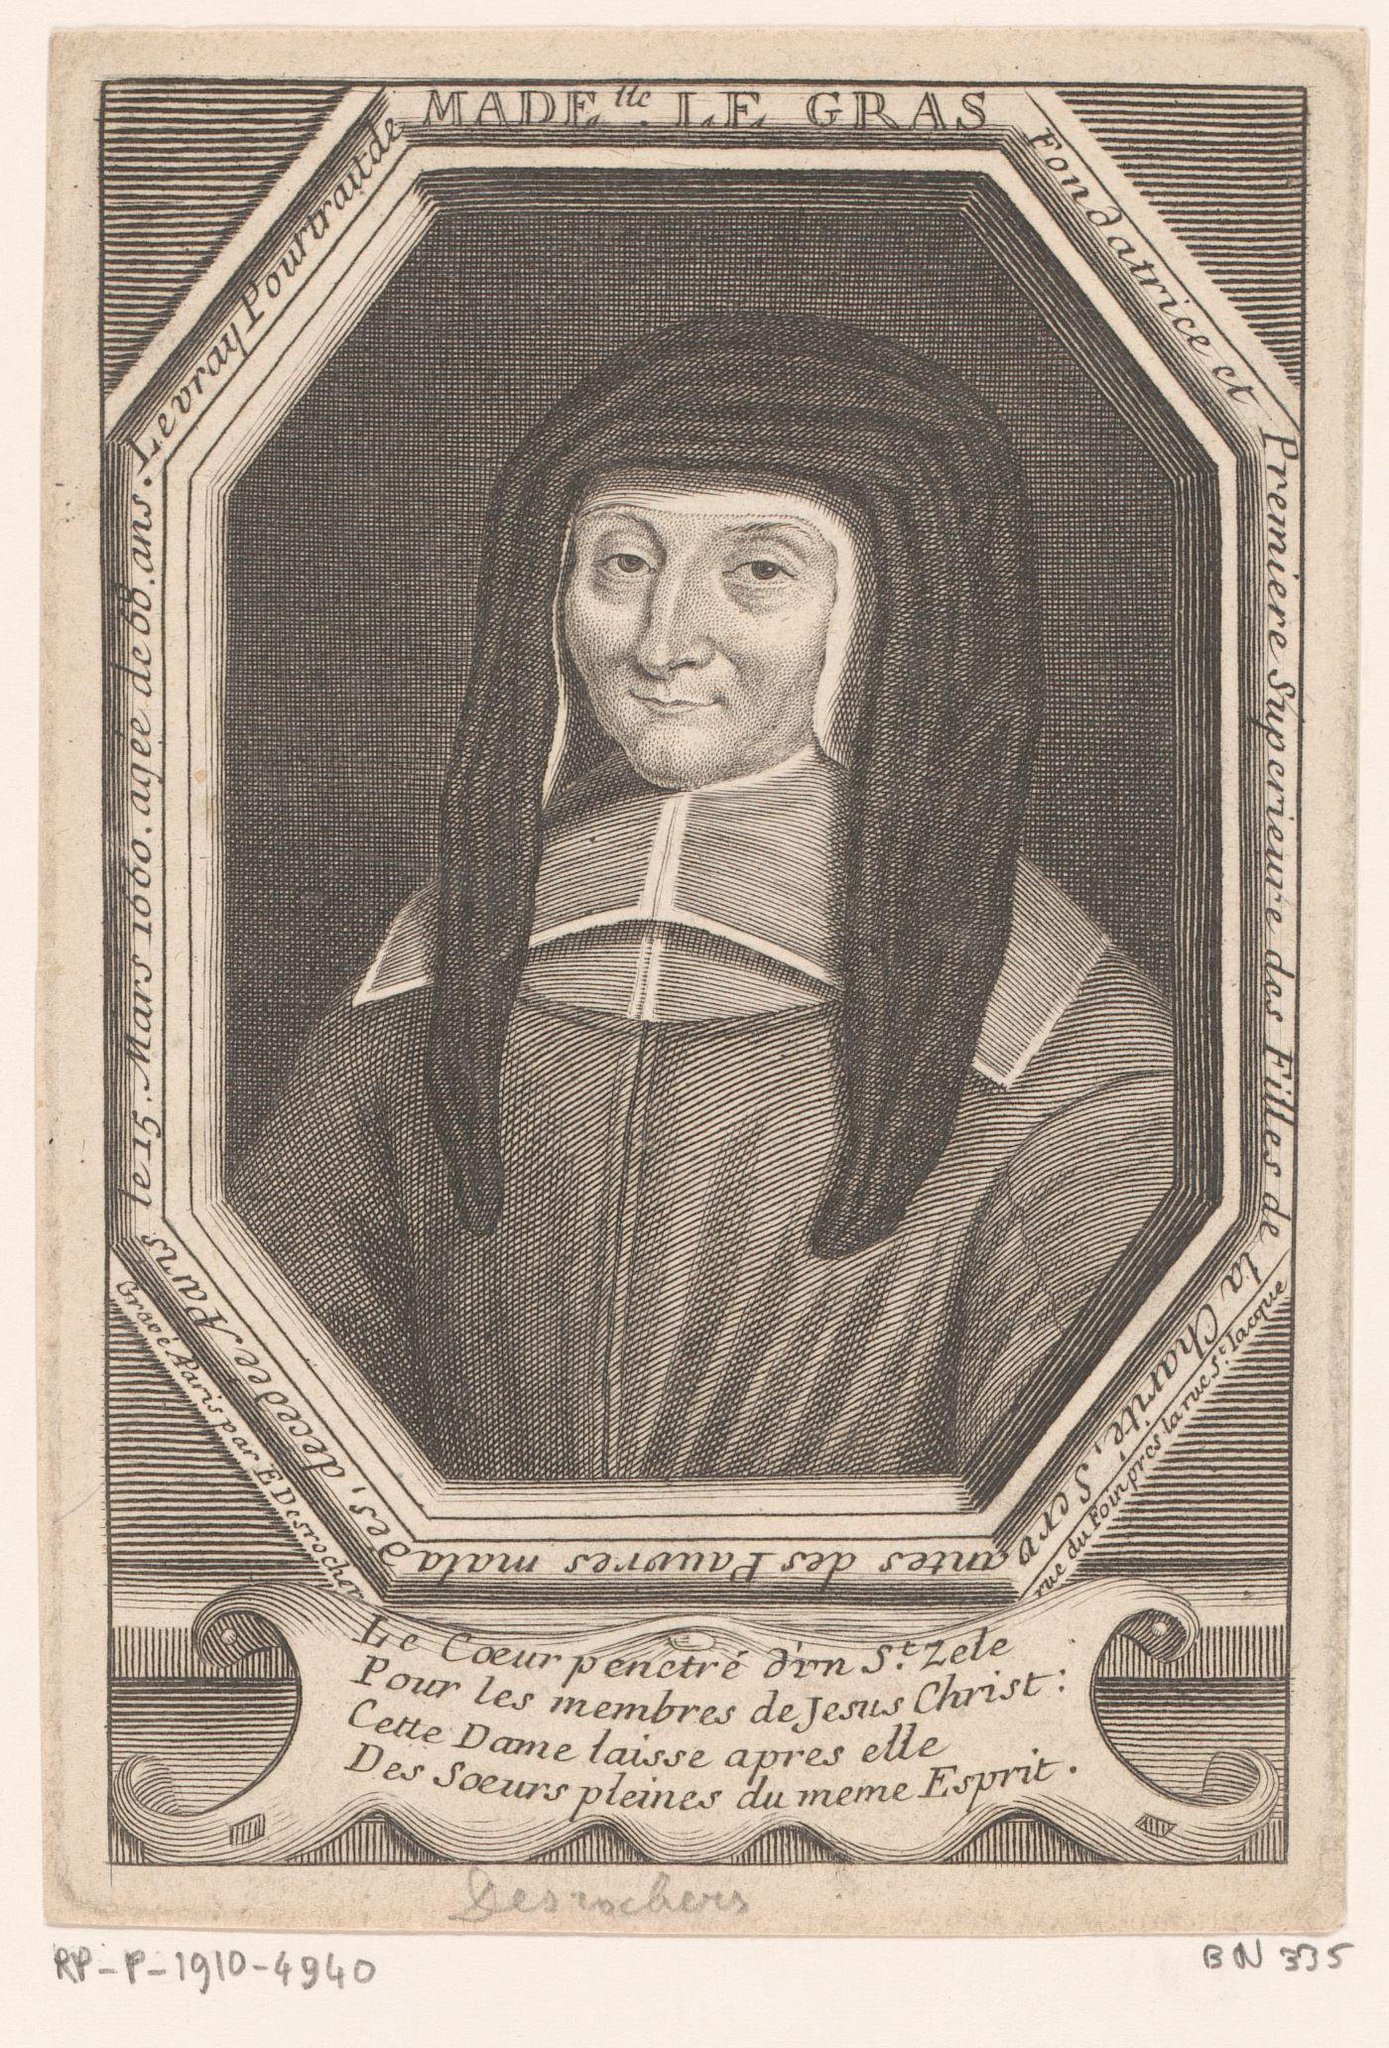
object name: print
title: Portret van Louise de Marillac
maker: étienne desrochers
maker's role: print maker, publisher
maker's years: 1668-1741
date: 1726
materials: paper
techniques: engraving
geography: paris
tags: paris, historical persons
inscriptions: collector's mark: Lugt 2228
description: Behoort waarschijnlijk tot een serie portretten, grotendeels door Etienne Desrochers, getiteld: 'Recueil de portraits de personnes qui se sont distinguées tant dans les Armes que dans Belles-Lettres et les Arts, comme aussi la famille royale de France et autres cours étrangères'. De serie werd initieel uitgegeven door Desrochers en aangekondigd in 'Mercure' in mei 1726, p. 985. Echter was Desrochers reeds enkele jaren eerder begonnen met het uitgeven van de serie. Na de dood van Desrochers werd de serie voortgezet door Gilles Edme Petit. Een latere staat werd uitgegeven door Jean François Daumont in Parijs.